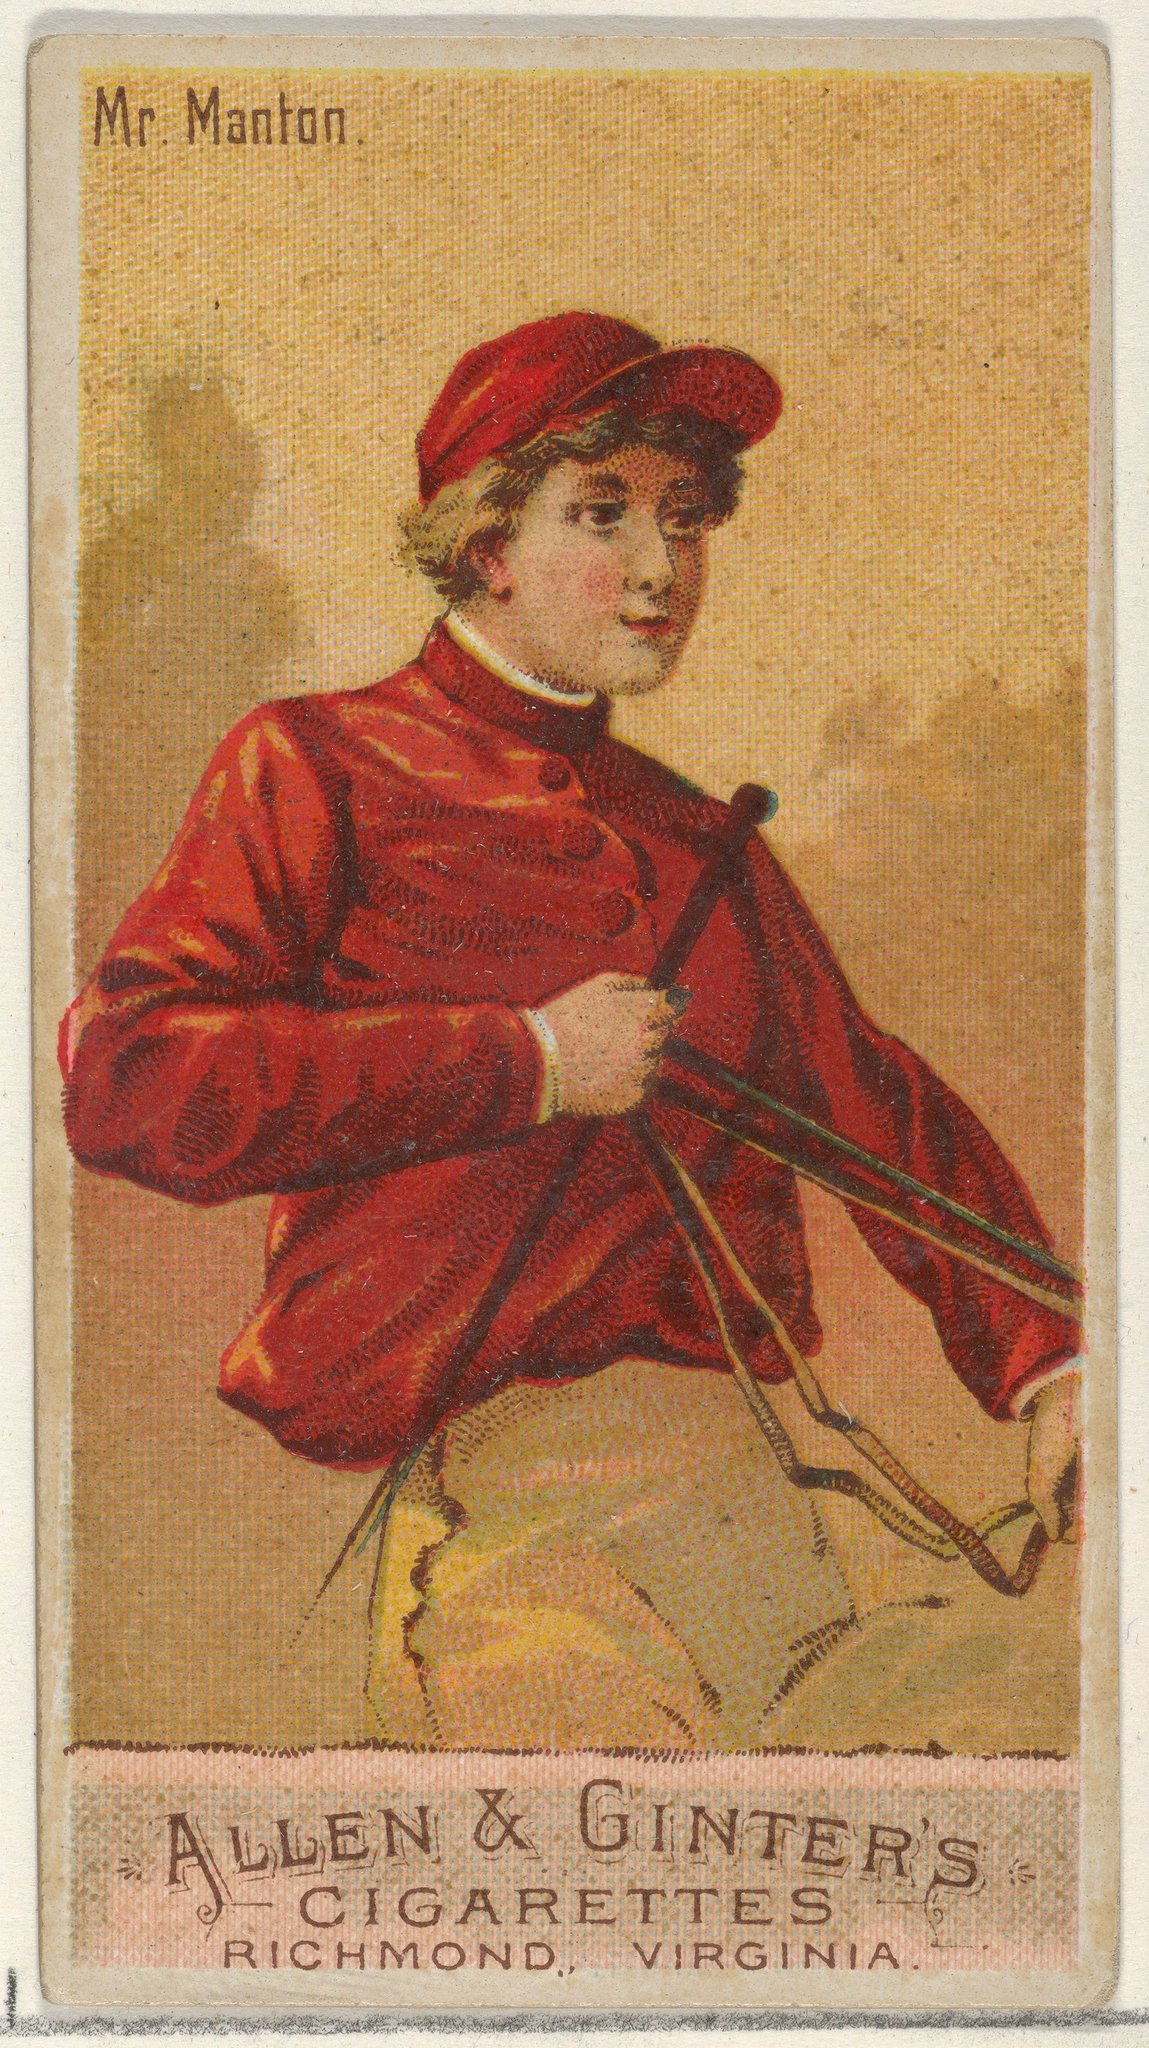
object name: print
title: Mr. Manton, from the Racing Colors of the World series (N22a) for Allen & Ginter Cigarettes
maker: allen & ginter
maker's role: publisher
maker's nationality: american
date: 1888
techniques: color lithograph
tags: men,jockeys